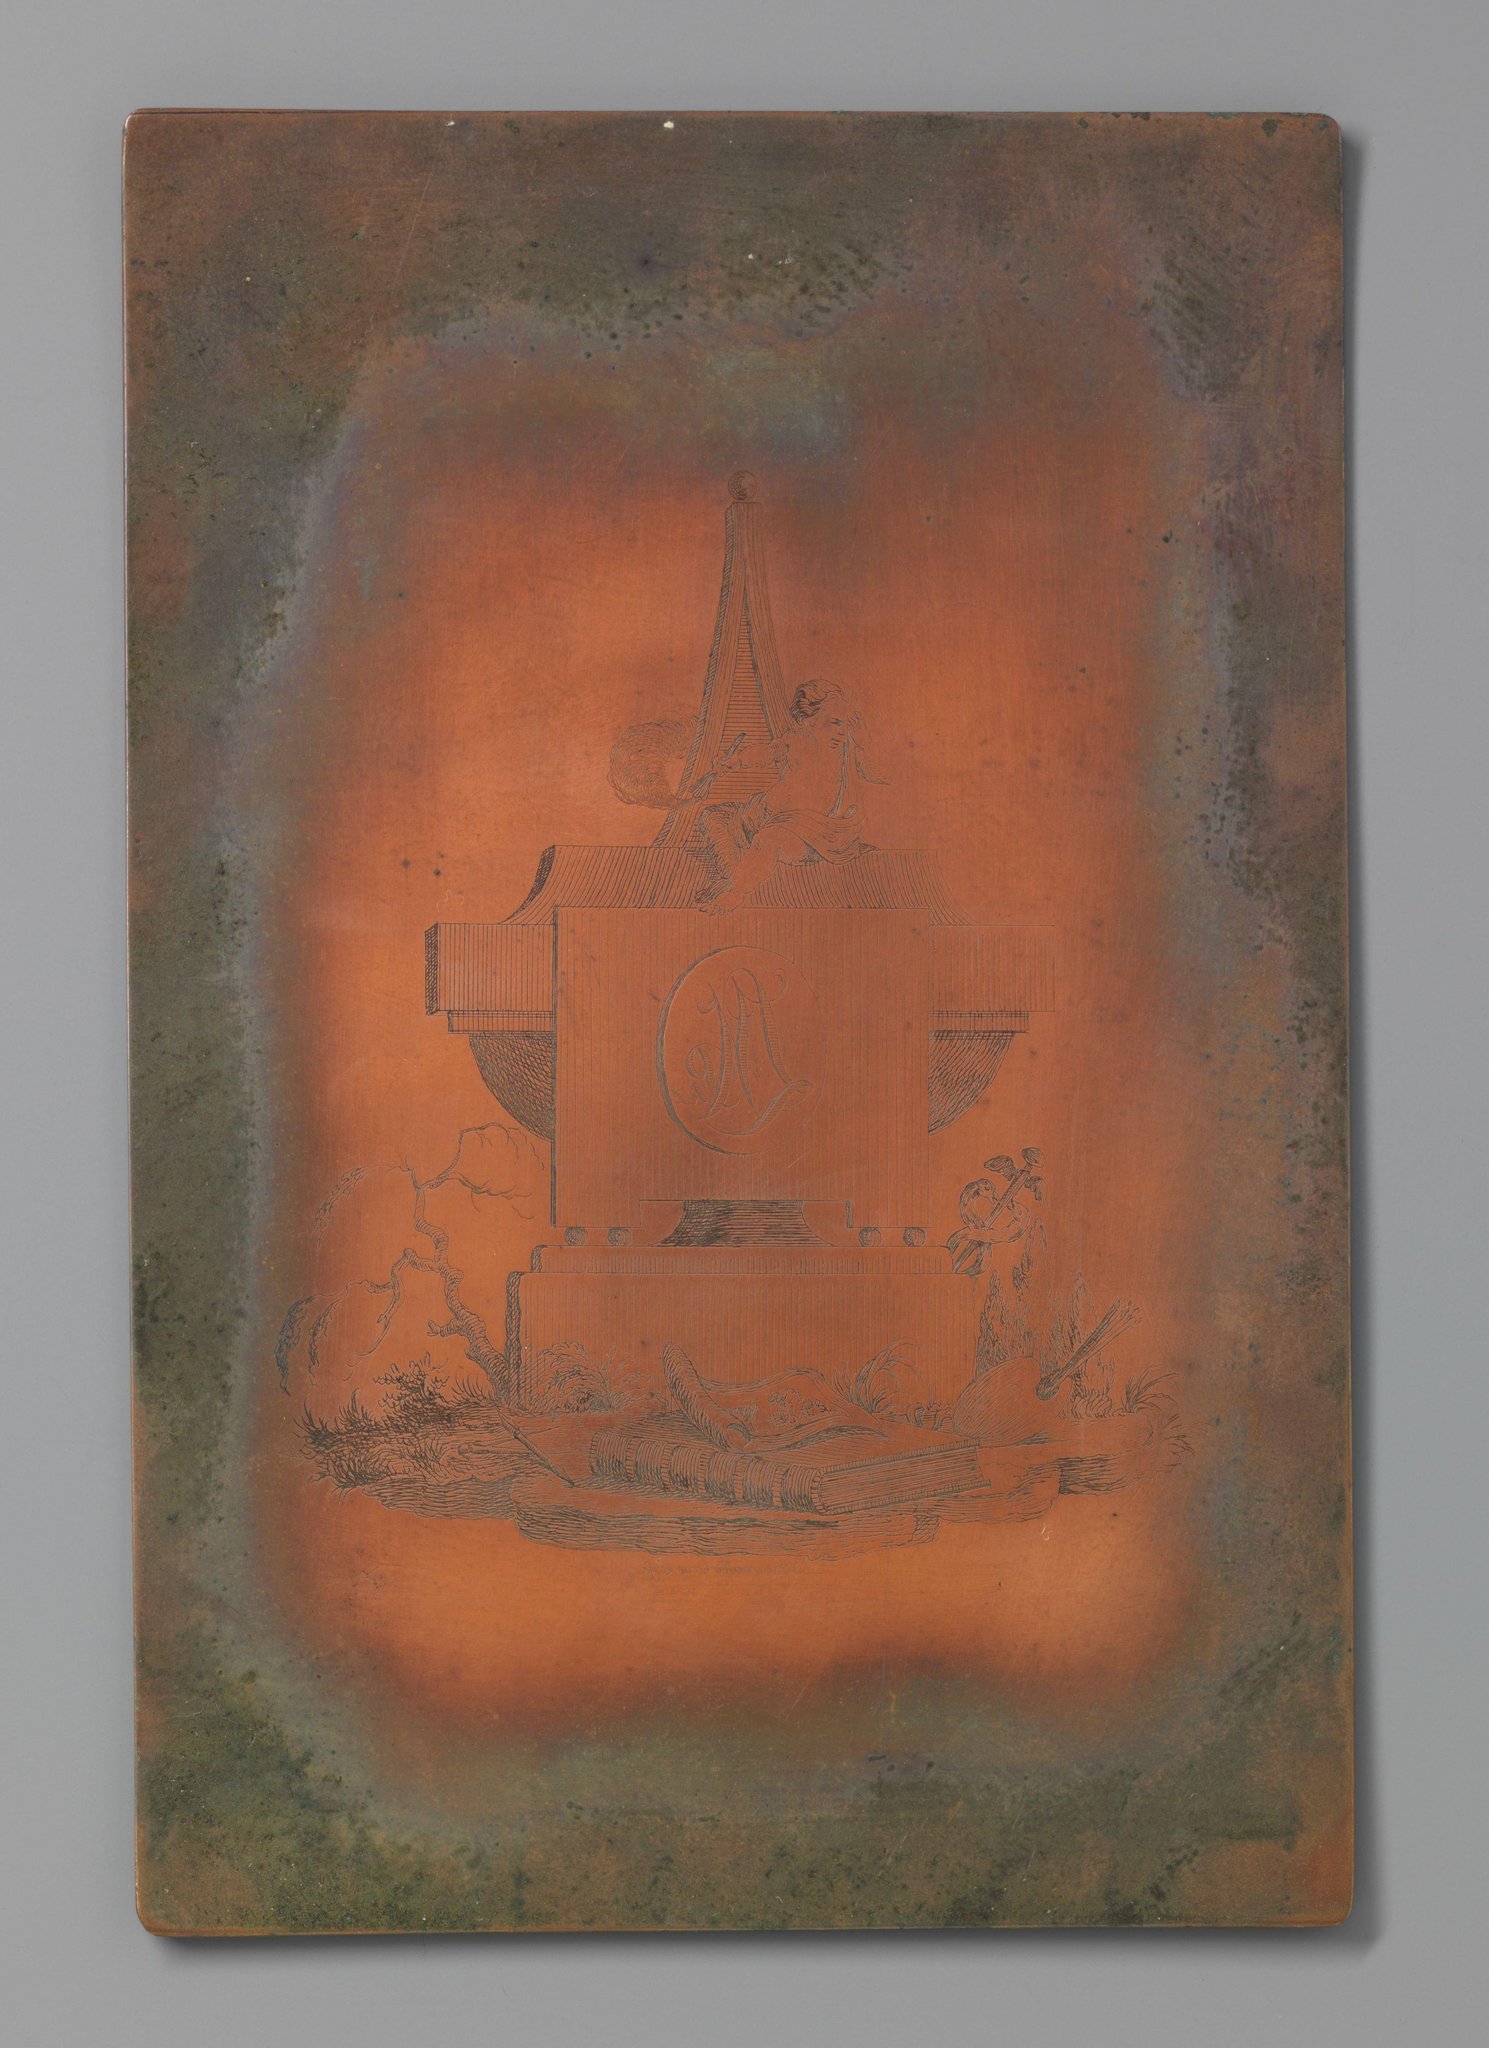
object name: copper plate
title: Grafmonument met monogram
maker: jean bernard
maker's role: draughtsman, print maker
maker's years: 1765-1833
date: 1799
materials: copper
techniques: etching